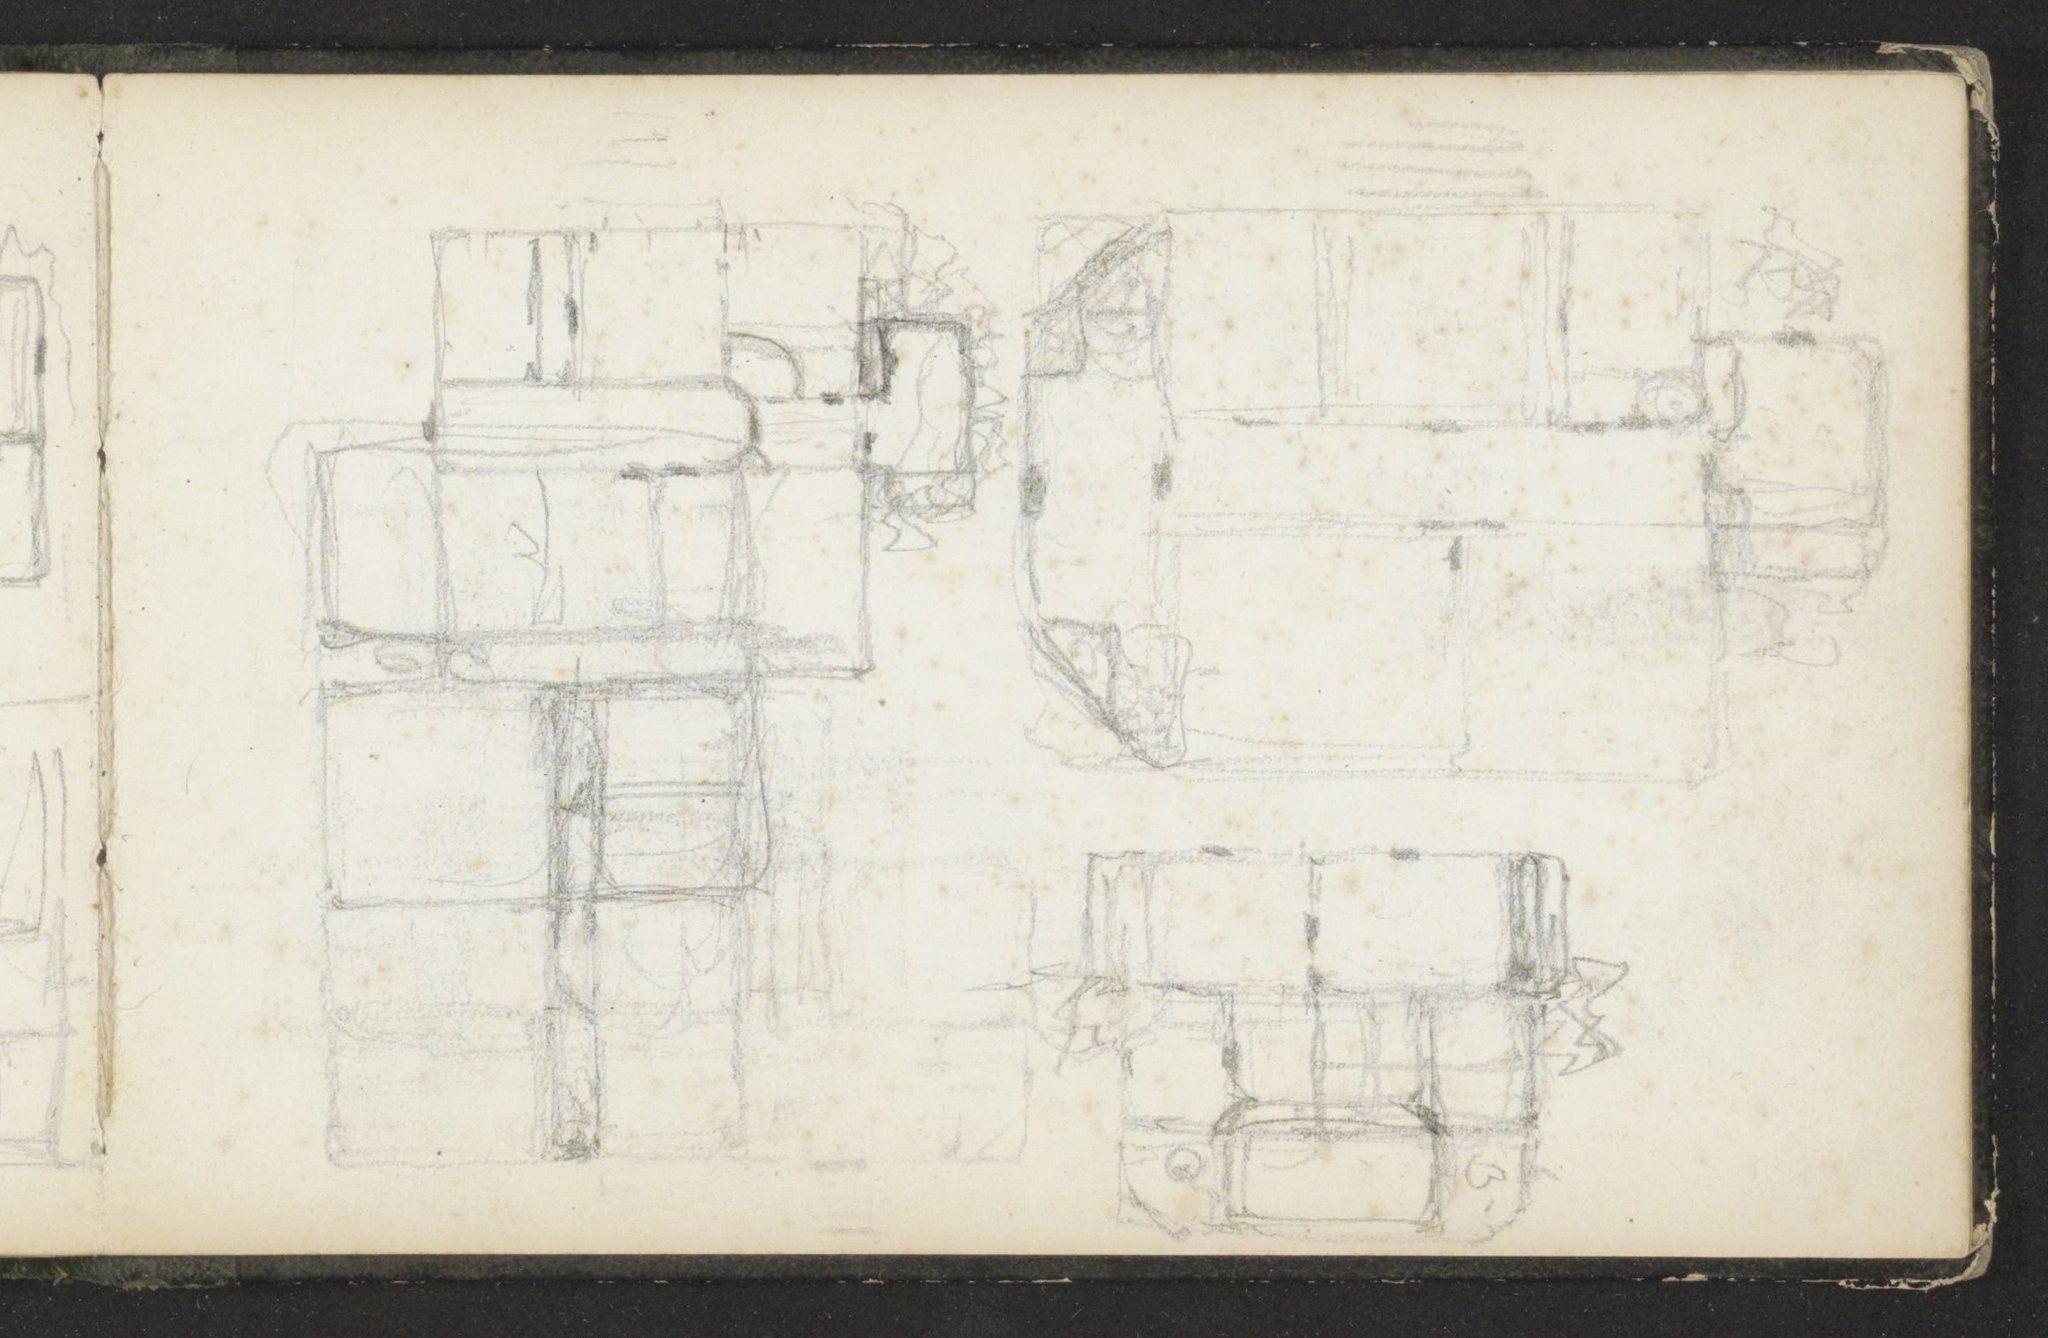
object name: sketchbook leaf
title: Ontwerp voor de plattegrond van Villa Grada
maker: maria vos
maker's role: draughtsman, painter, print maker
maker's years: 1824-1906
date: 1856-1870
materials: paper, pencil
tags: plan ~ architecture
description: In 1870 lieten Maria Vos en haar vriendin Adriana Haanen in Oosterbeek een eigen huis met de naam Villa Grada bouwen.